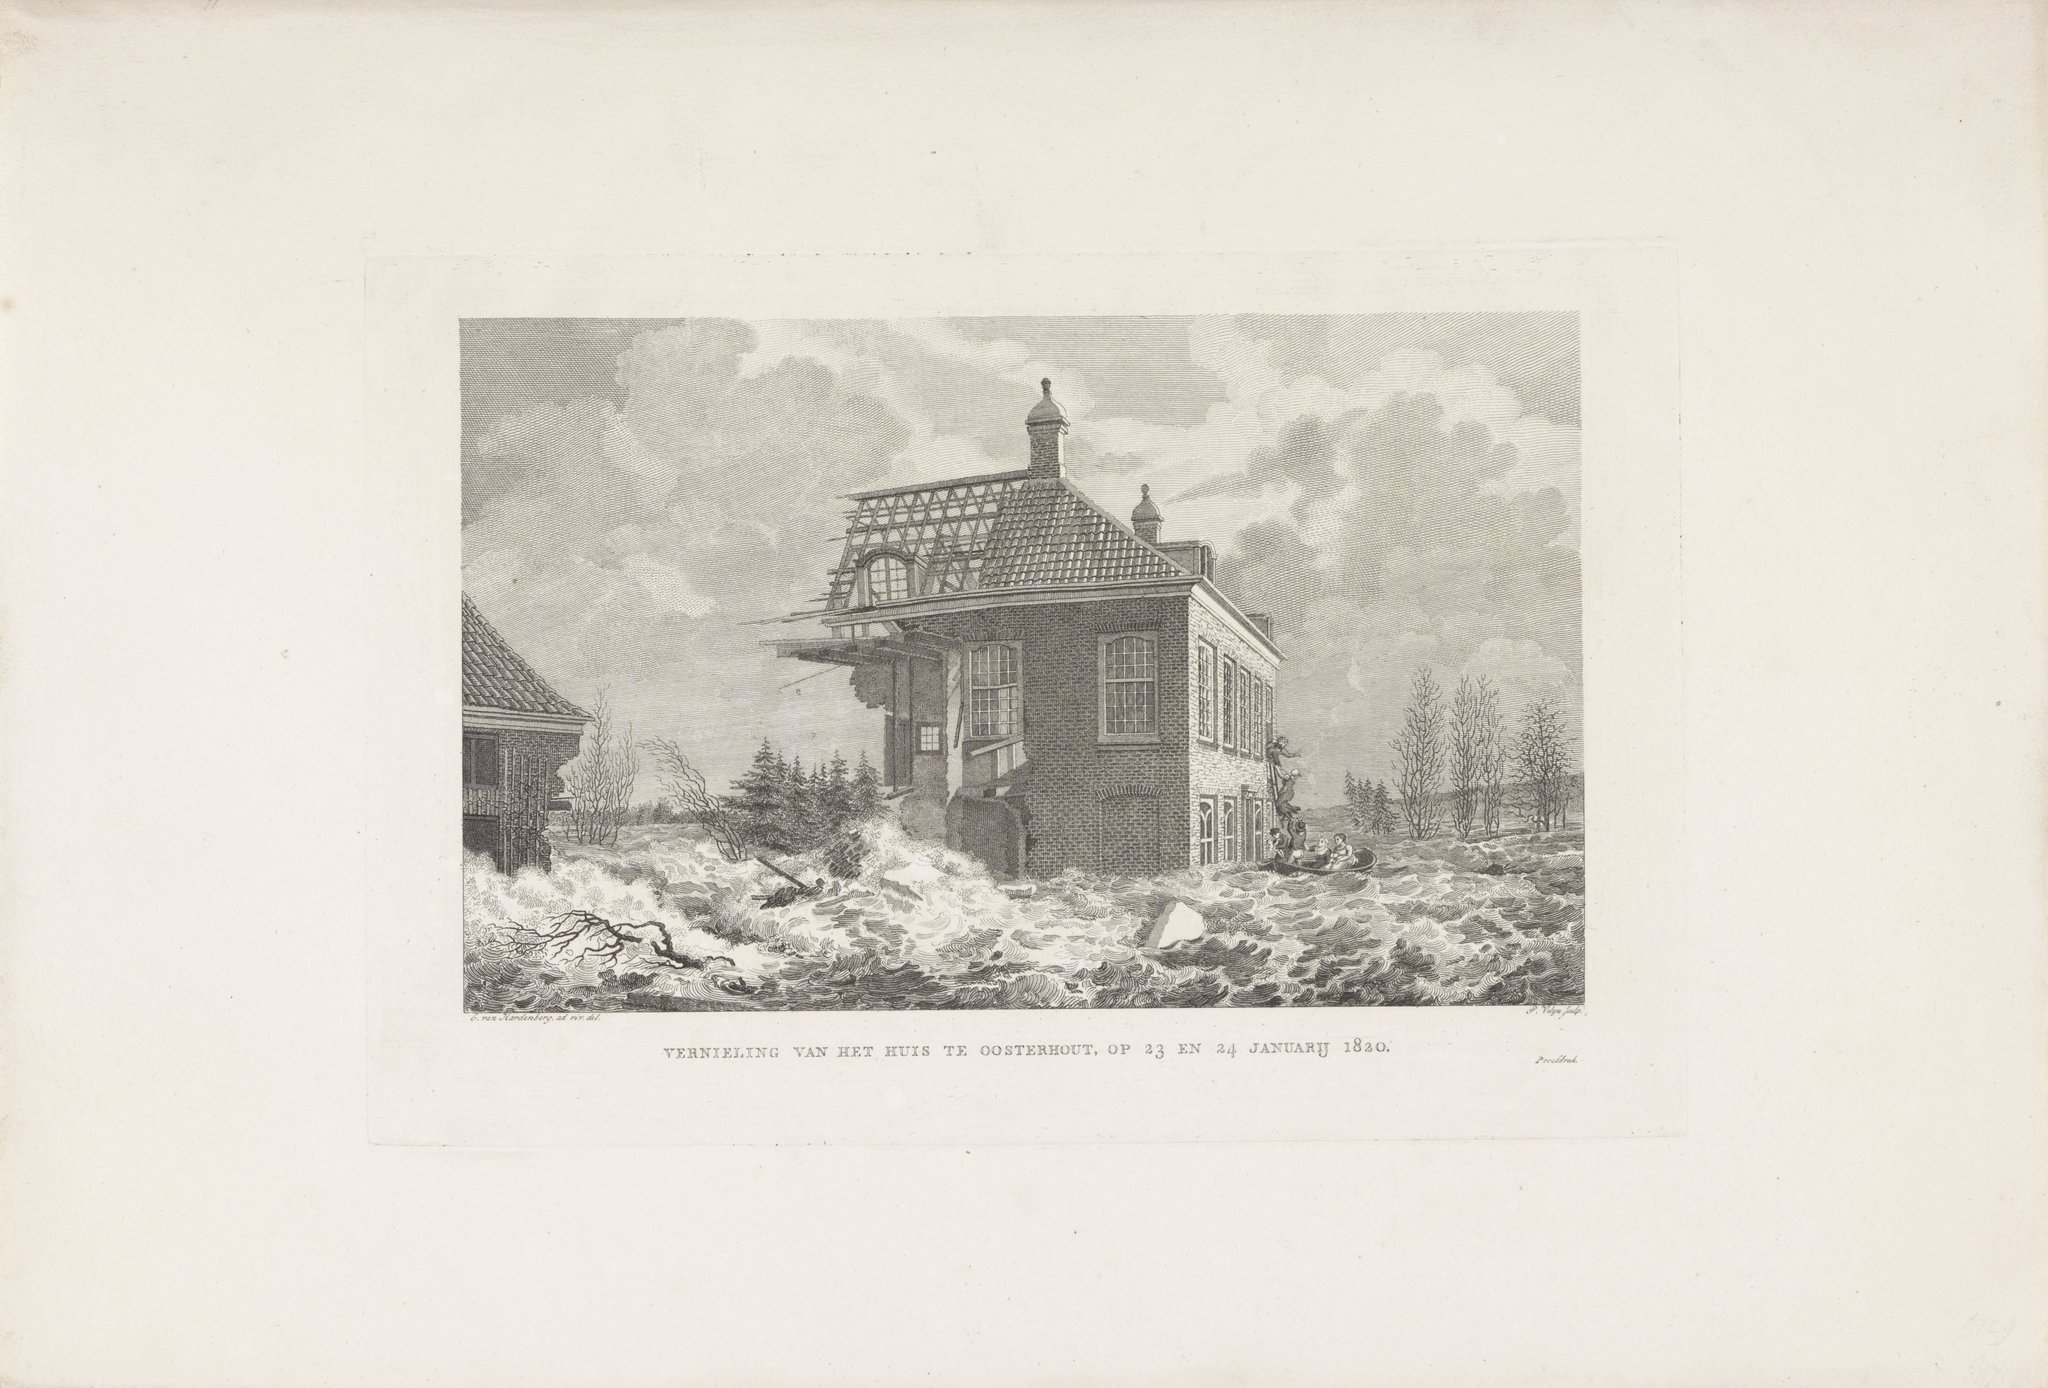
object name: print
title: Vernieling van het Huis te Oosterhout, op 23 en 24 Januarij 1820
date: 1820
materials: paper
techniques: engraving, etching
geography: netherlands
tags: flood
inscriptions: collector's mark: Lugt 2228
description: Huis te Oosterhout, bij Nijmegen, vernield door het water tijdens de overstroming op 23 en 24 januari 1820. Bomen worden door het woeste water meegesleurd, rechts een schuit waarmee de bewoners van het huis worden gered. Onderdeel van een groep van illustraties uit een boek over de watersnood van 1820.